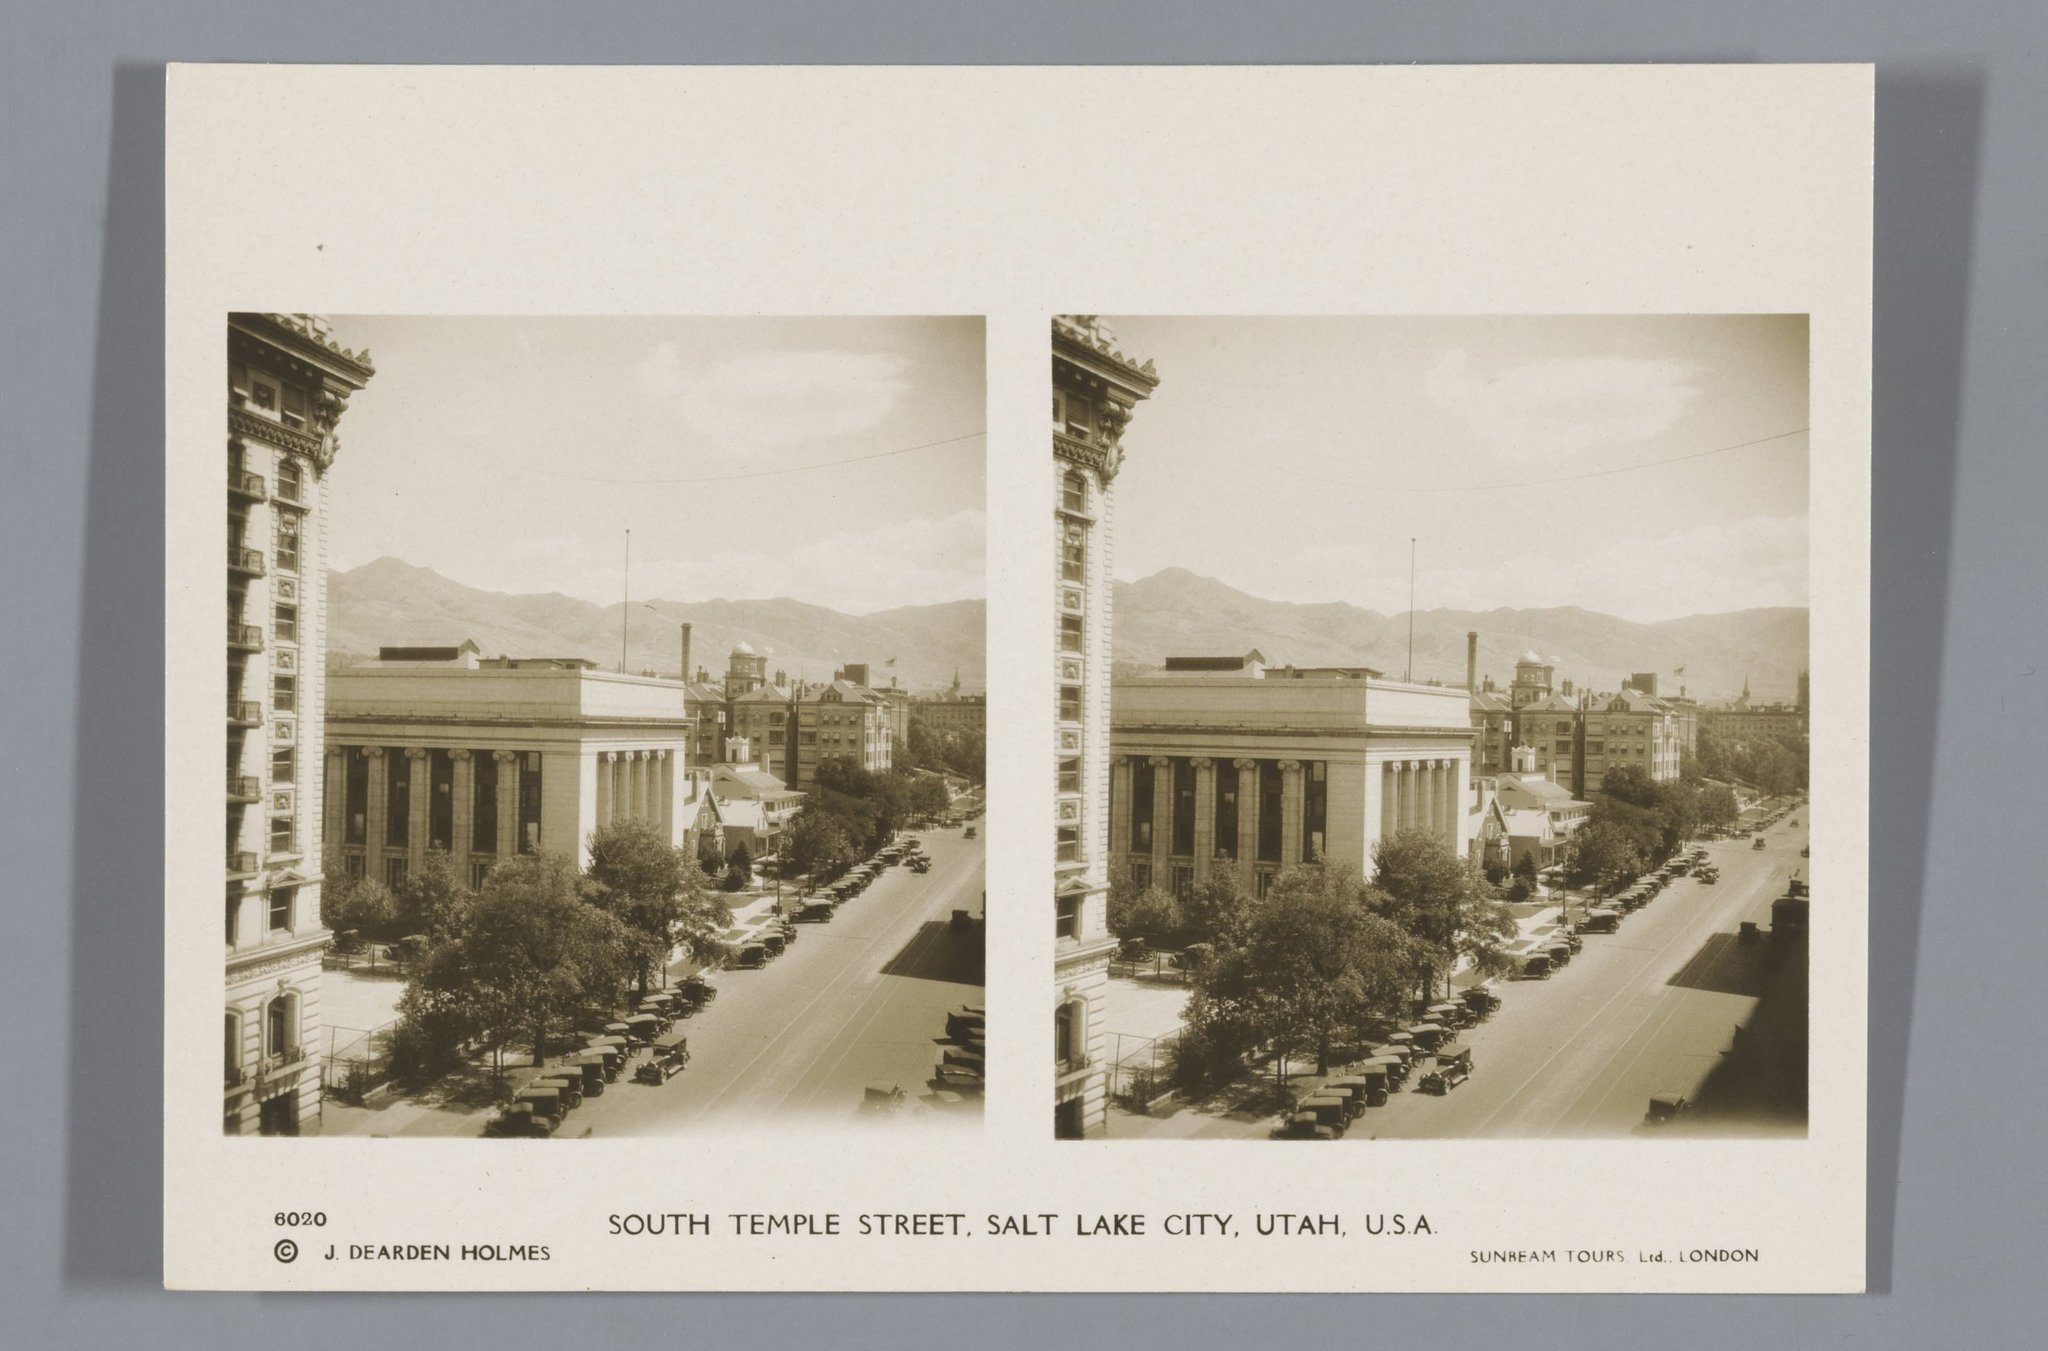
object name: stereograph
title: South Temple Street, Salt Lake City, Utah, U.S.A.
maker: james dearden holmes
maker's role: fotograaf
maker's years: 1873-1937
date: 1924-1926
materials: paper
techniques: gelatin silver print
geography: salt lake city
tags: street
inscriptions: number: ‘6020’